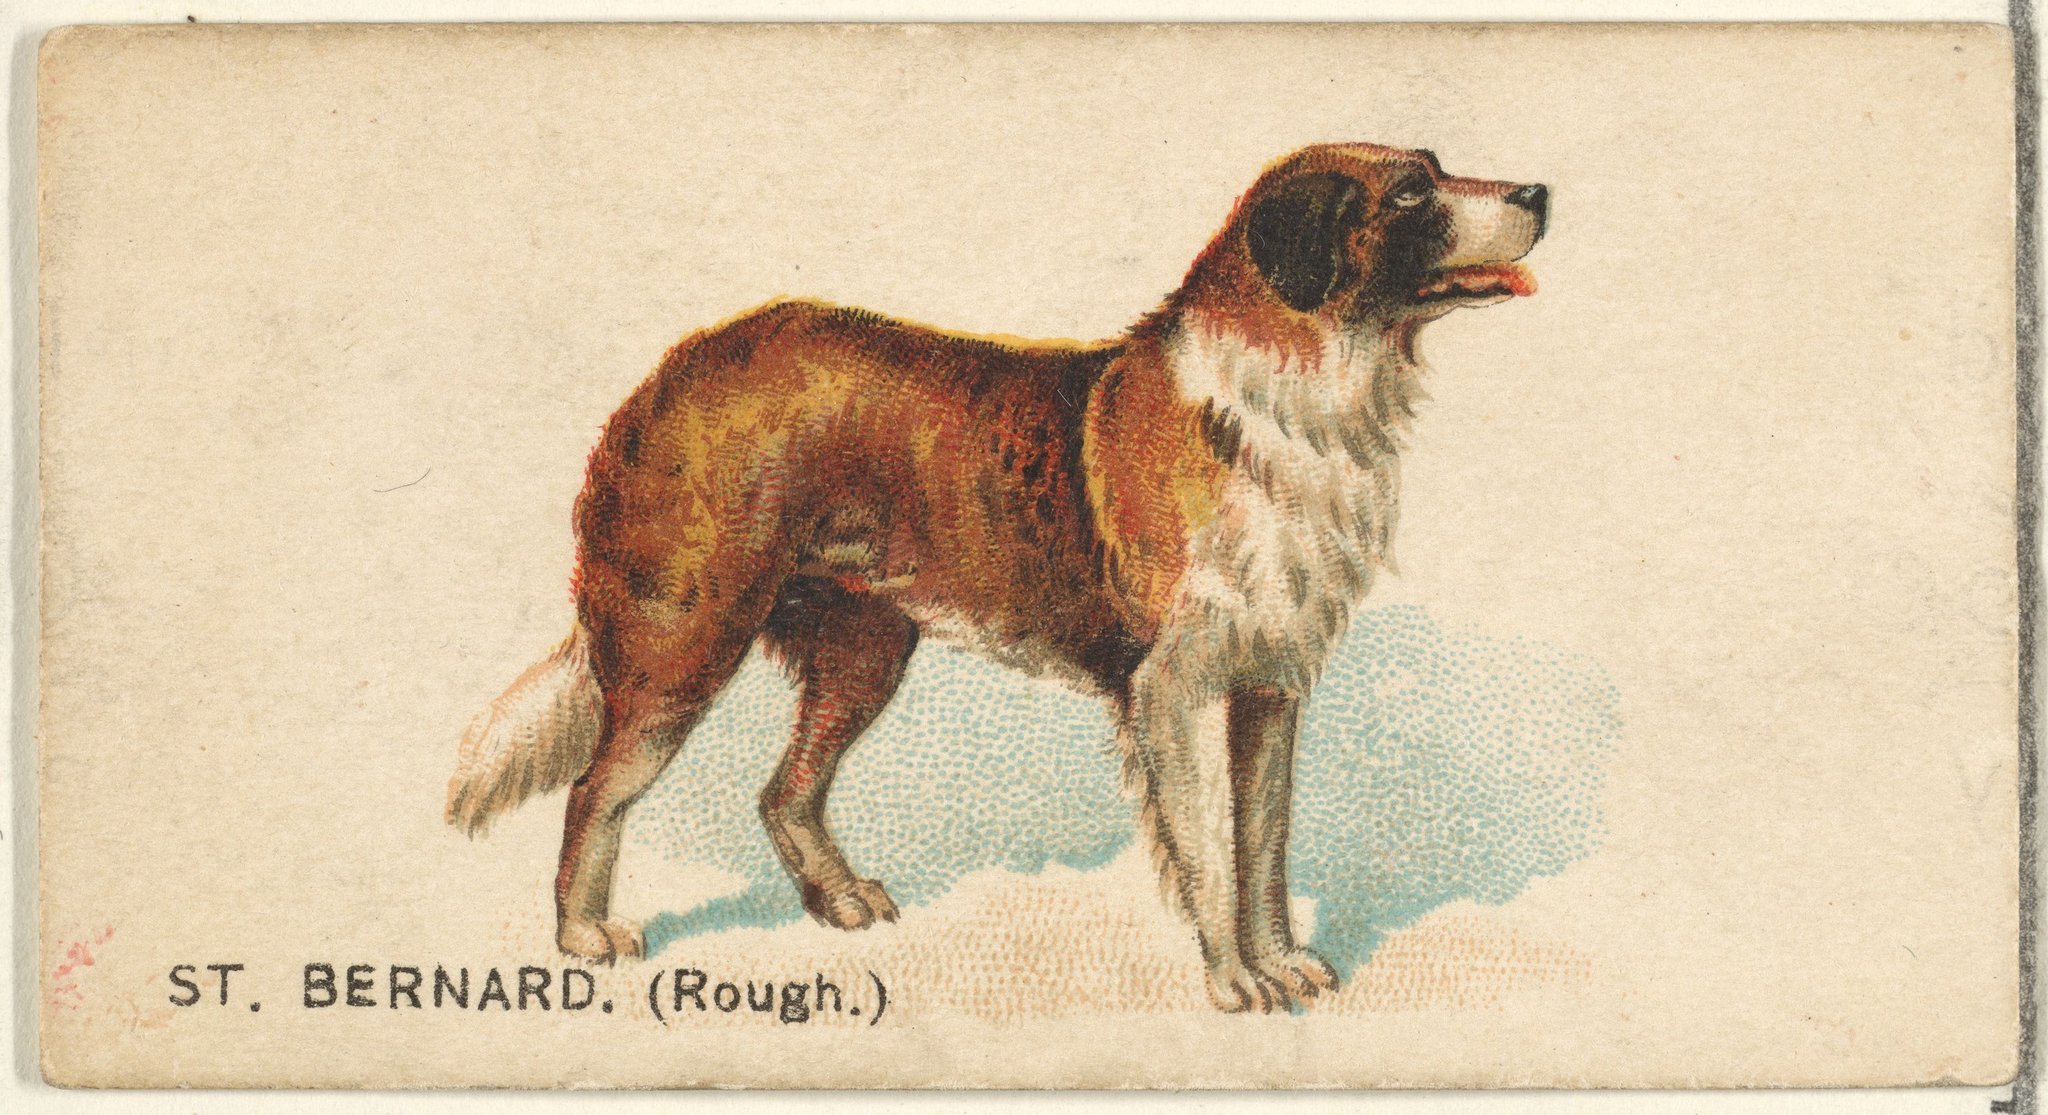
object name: print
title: St. Bernard (Rough), from the Dogs of the World series for Old Judge Cigarettes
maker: goodwin & company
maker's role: publisher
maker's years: 1850-1950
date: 1890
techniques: color lithograph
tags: dogs